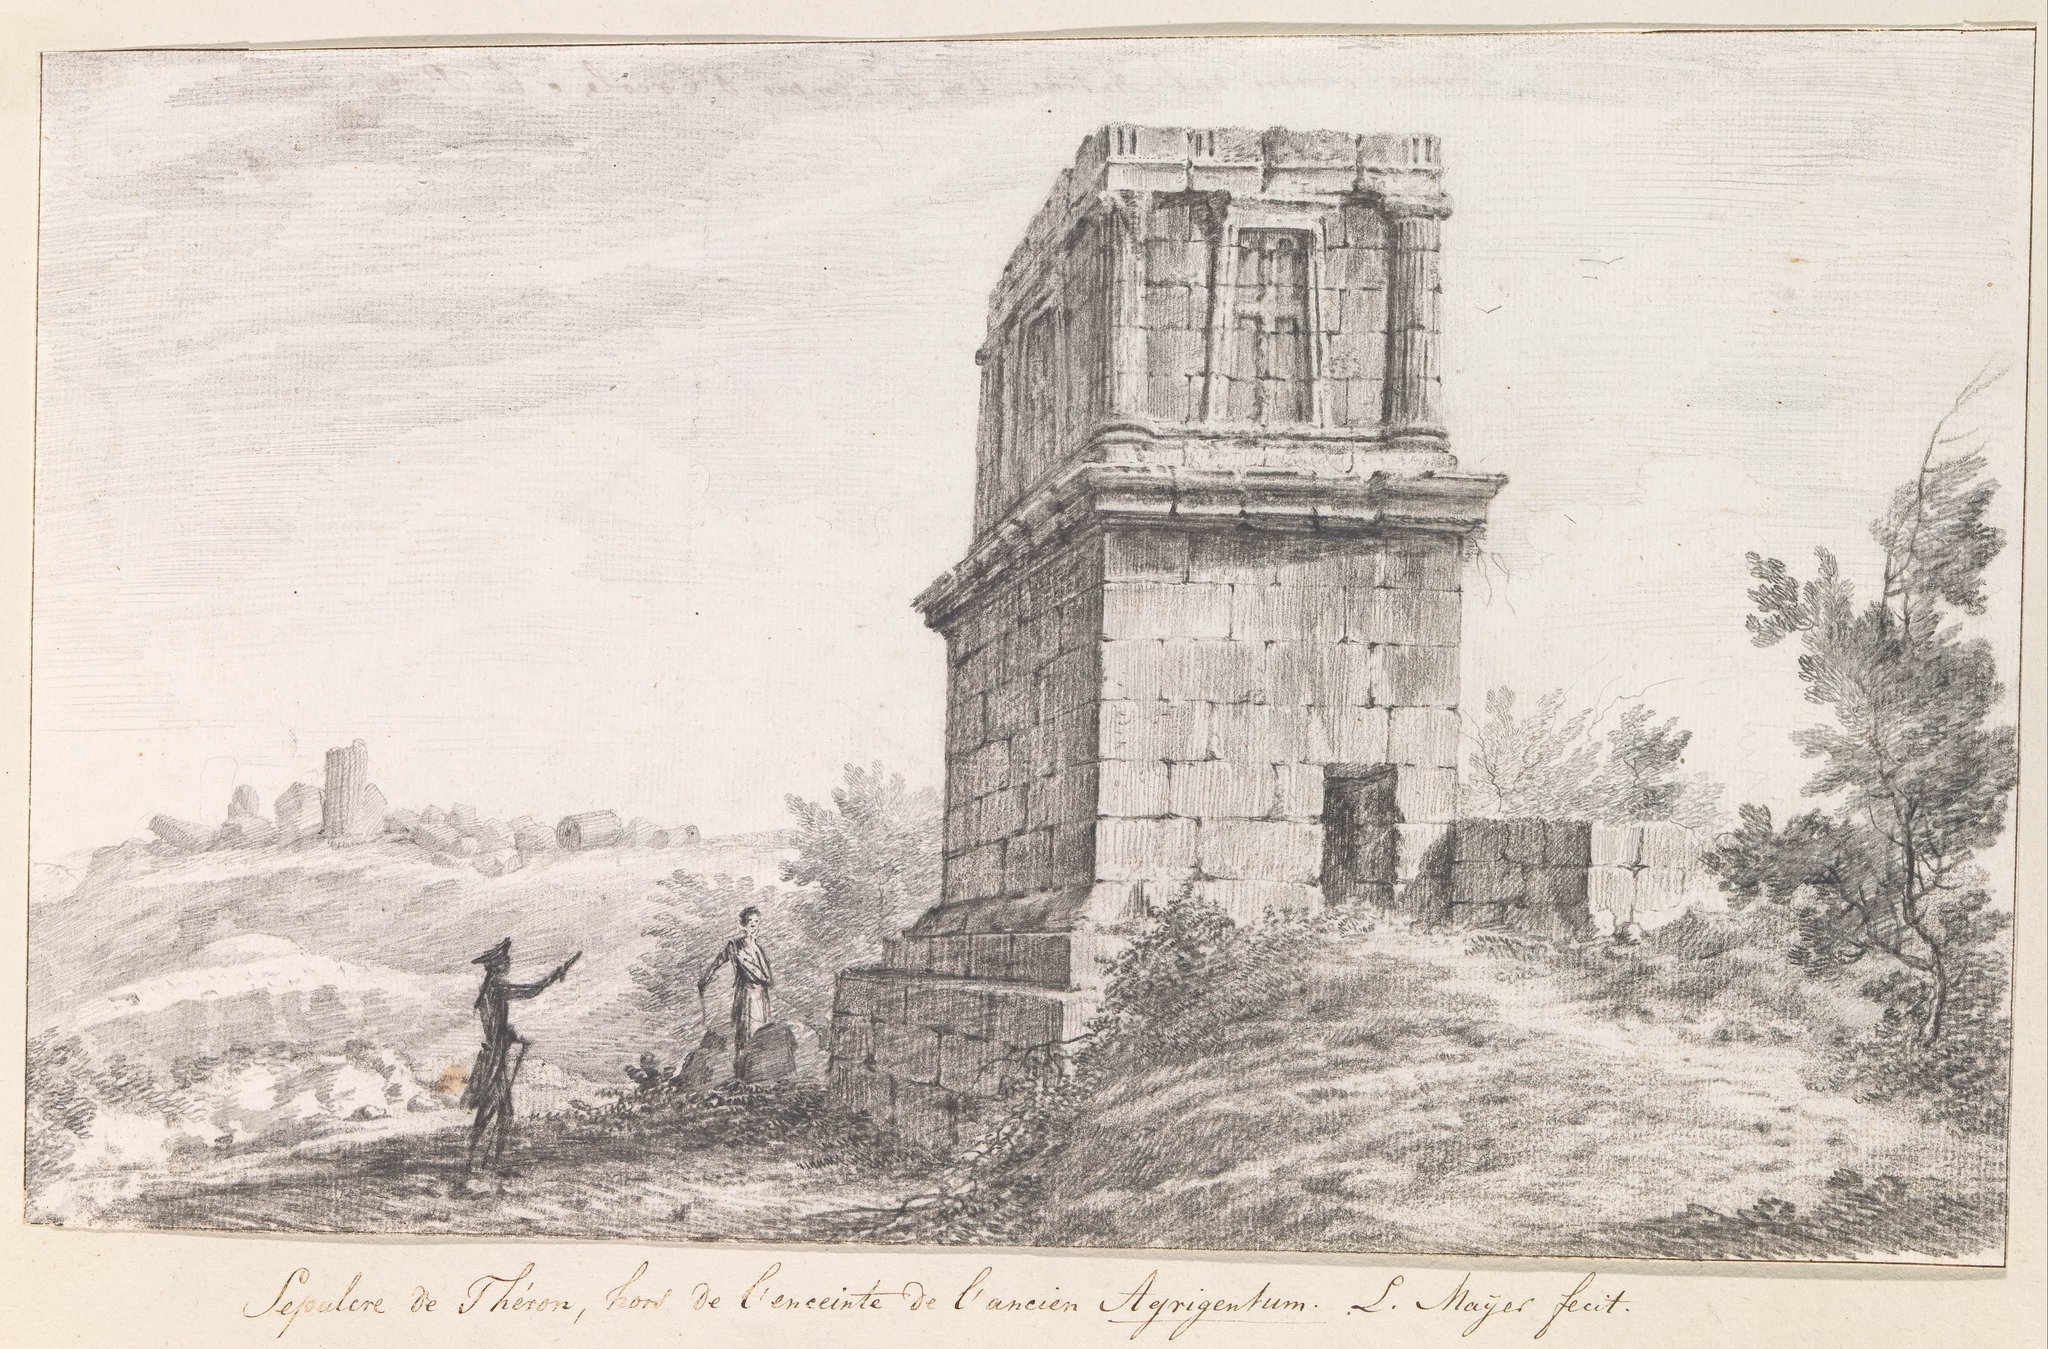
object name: drawing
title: Voyage en Italie, en Sicile et à Malte - 1778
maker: louis mayer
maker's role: draughtsman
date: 1778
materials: chalk, paper, pencil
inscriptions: inscription: ‘Veduta del Sepolcro di Terone, fuori de l'Antico. Con il Tempio d'Ercole e la Porta Aucca [Aurea]’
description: Tekening uit het album 'Voyage en Italie, en Sicile et à Malte', 1778.